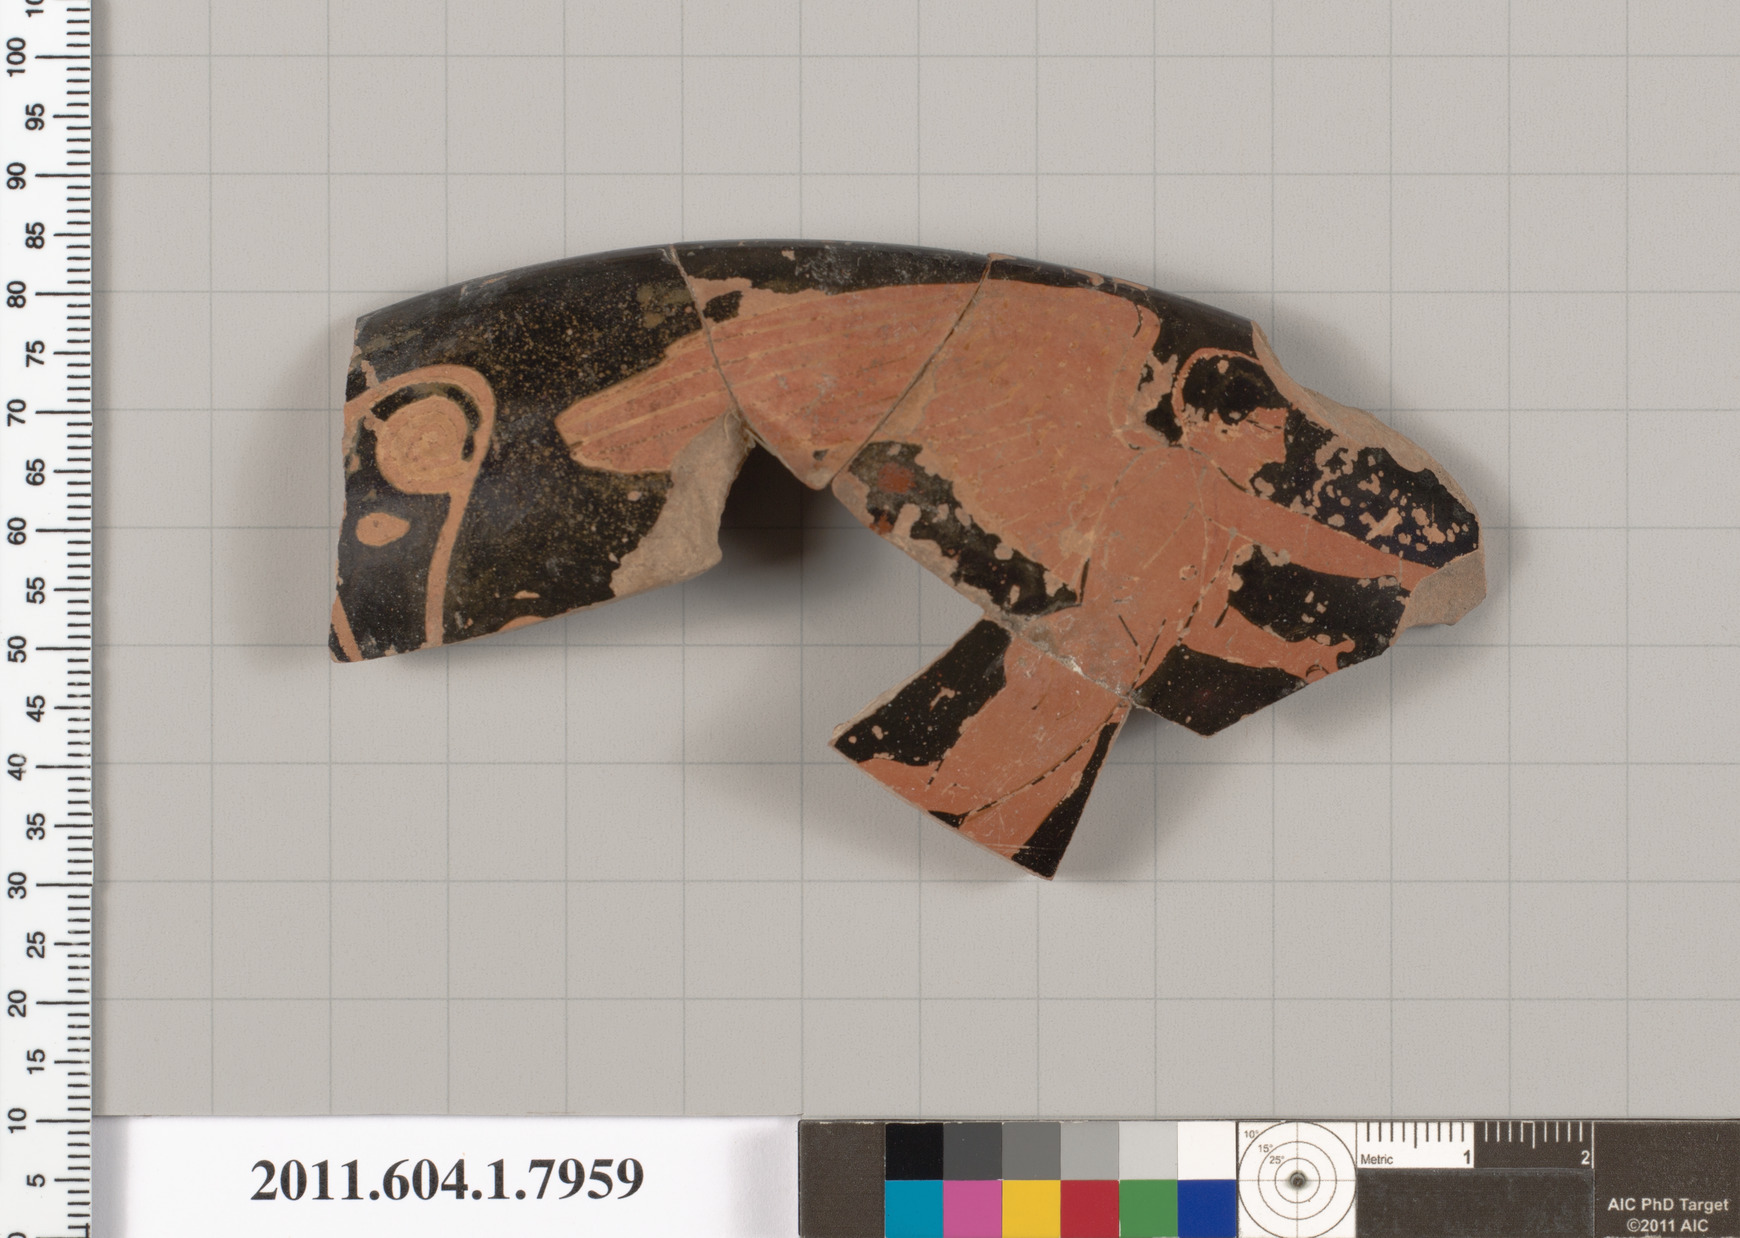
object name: kylix fragment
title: Terracotta rim fragment of a kylix (drinking cup)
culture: greek, attic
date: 460-450 BCE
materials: terracotta